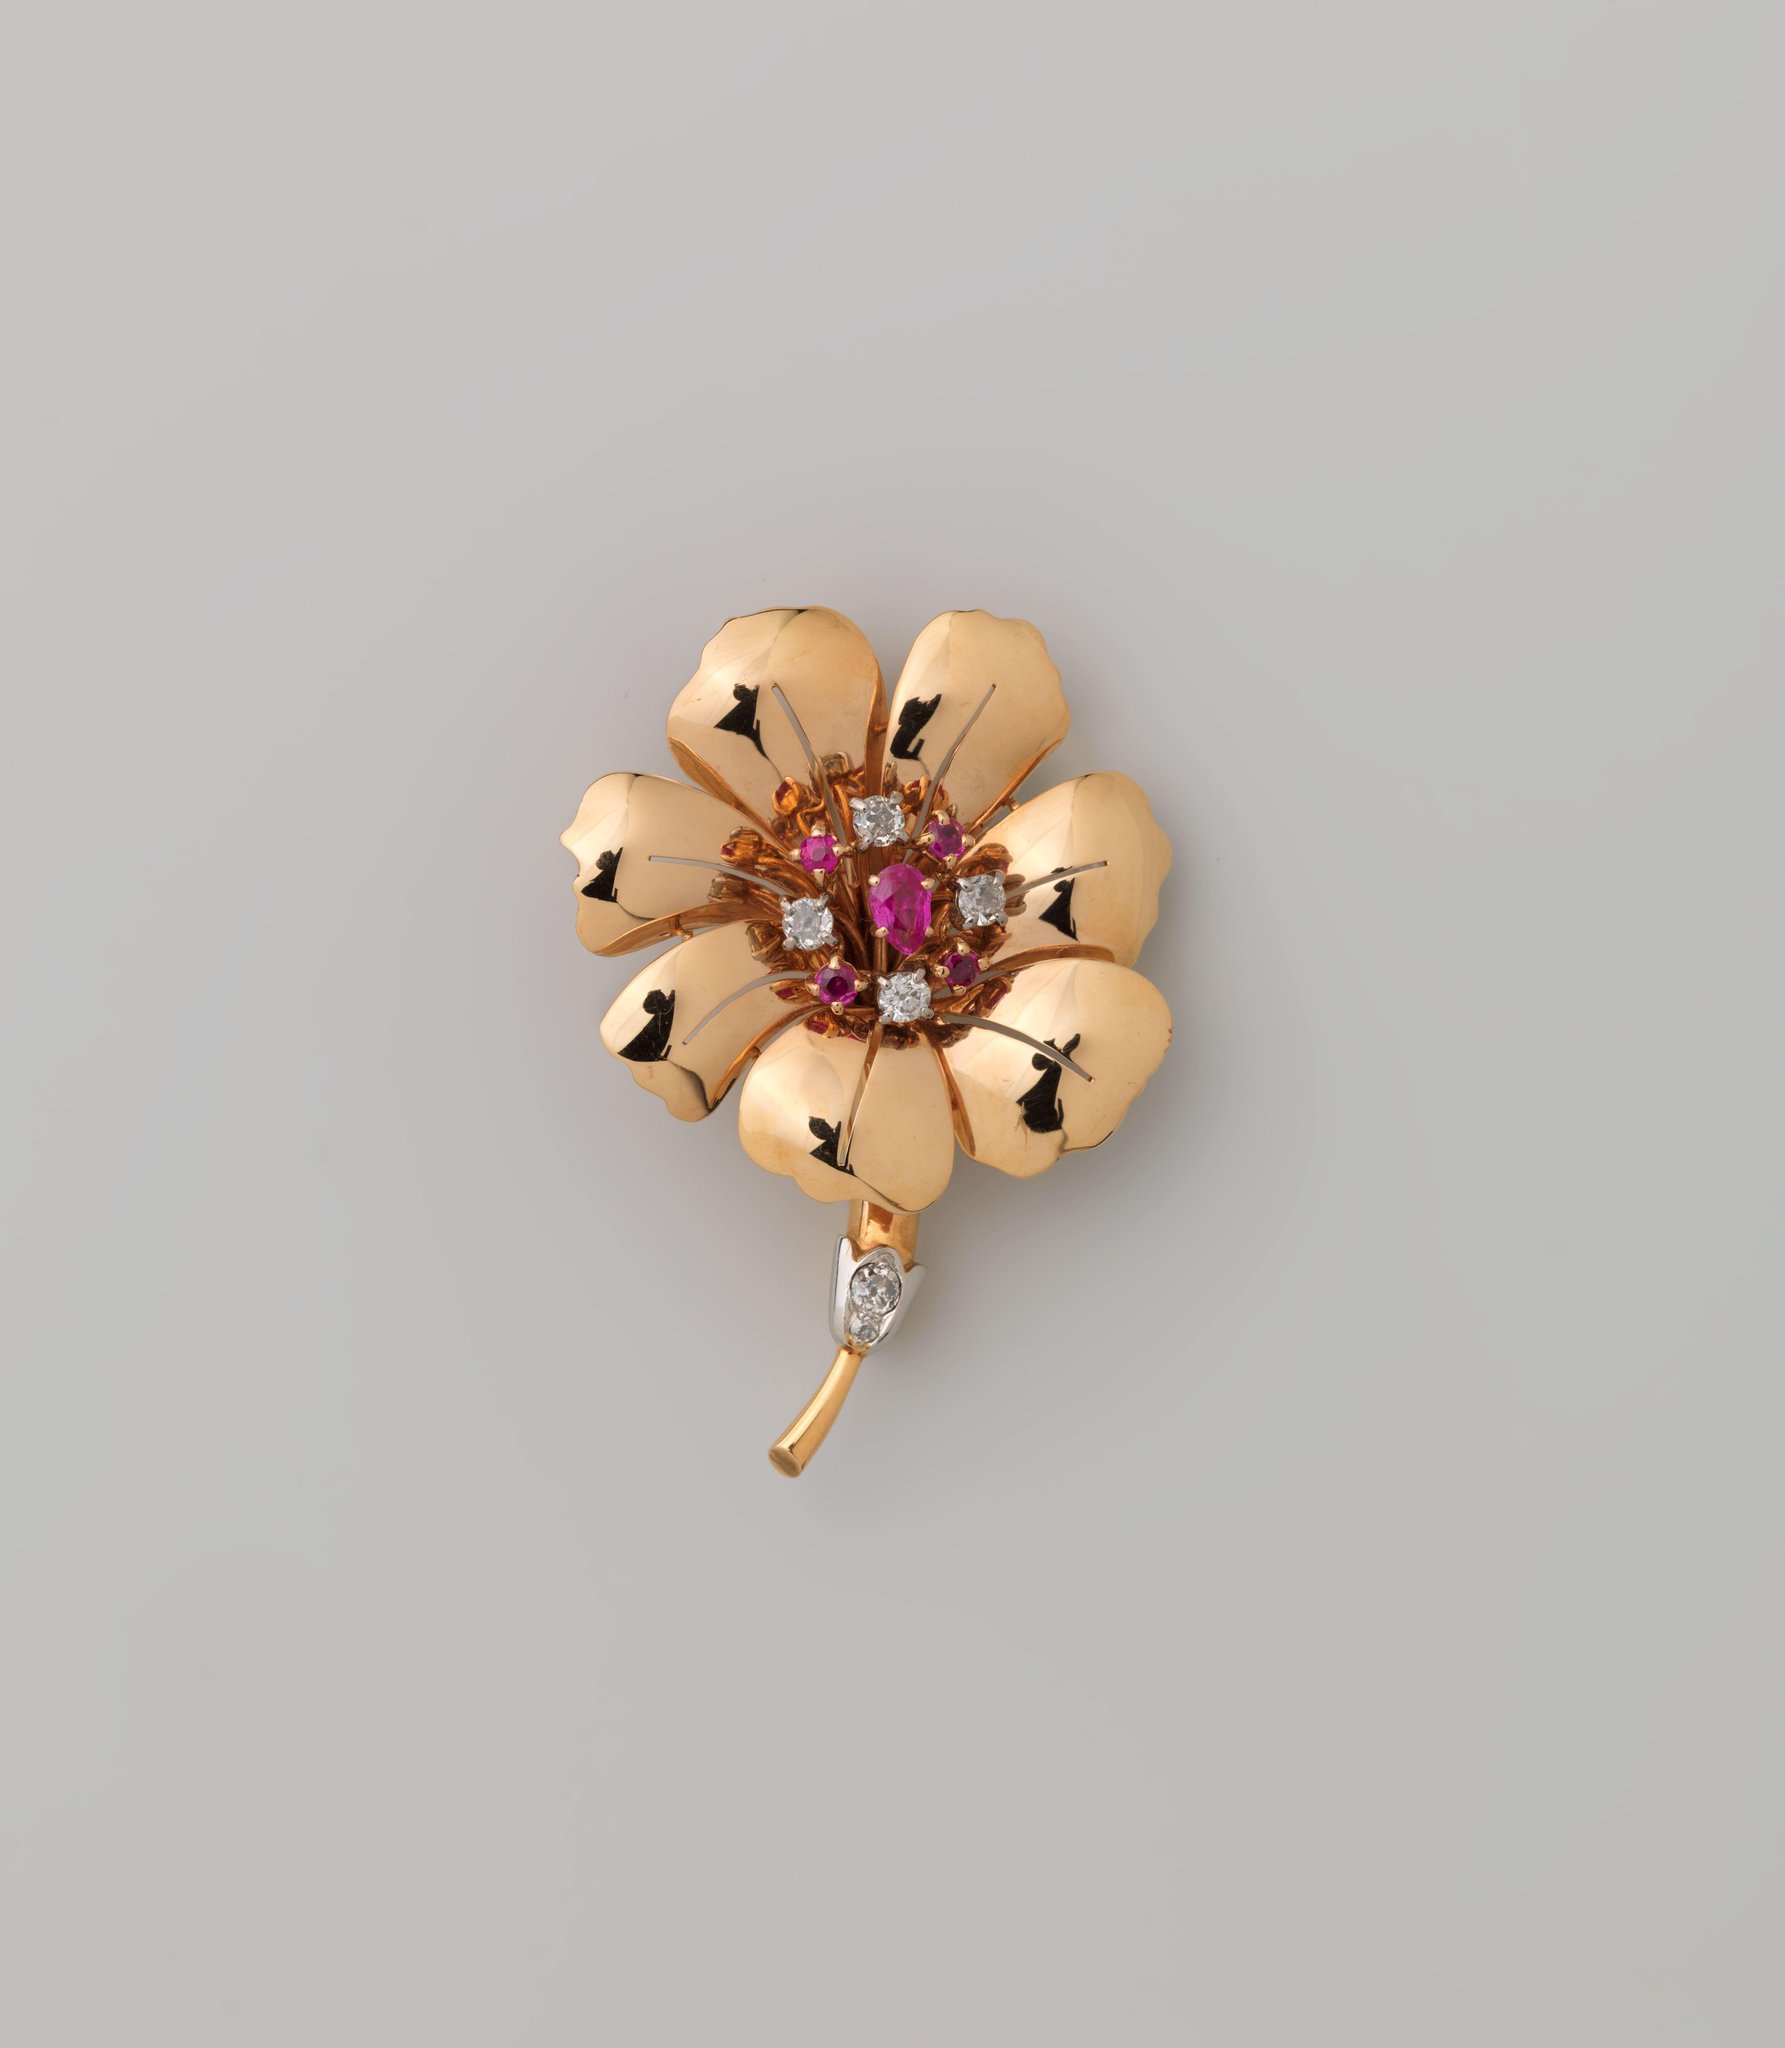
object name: brooch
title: Broche van goud met robijn en diamanten in doos met deksel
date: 1945-1953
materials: diamond, gold, gemstone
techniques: grinding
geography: the hague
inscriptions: maker's mark: ‘V.Z.K.’, alloy mark: ‘leeuw, zogenaamde kies’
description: Broche van goud in de vorm van een bloem met centraal een rozet met daarin een pendaloque geslepen robijn in entourage van vier rond gefacetteerde robijnen en drie gefacetteerde diamanten, voorzien van een kanonsluiting. In de steel in witgoud gezet twee gefacetteerde diamanten. De doos van zwart karton met fluwelen en zijden voering. Binnenzijde deksel: Ans Hemke-Kuilboer Juwelier - Antiquair AMSTERDAM. Deksel met sluitsysteem. Gouden sierrand.